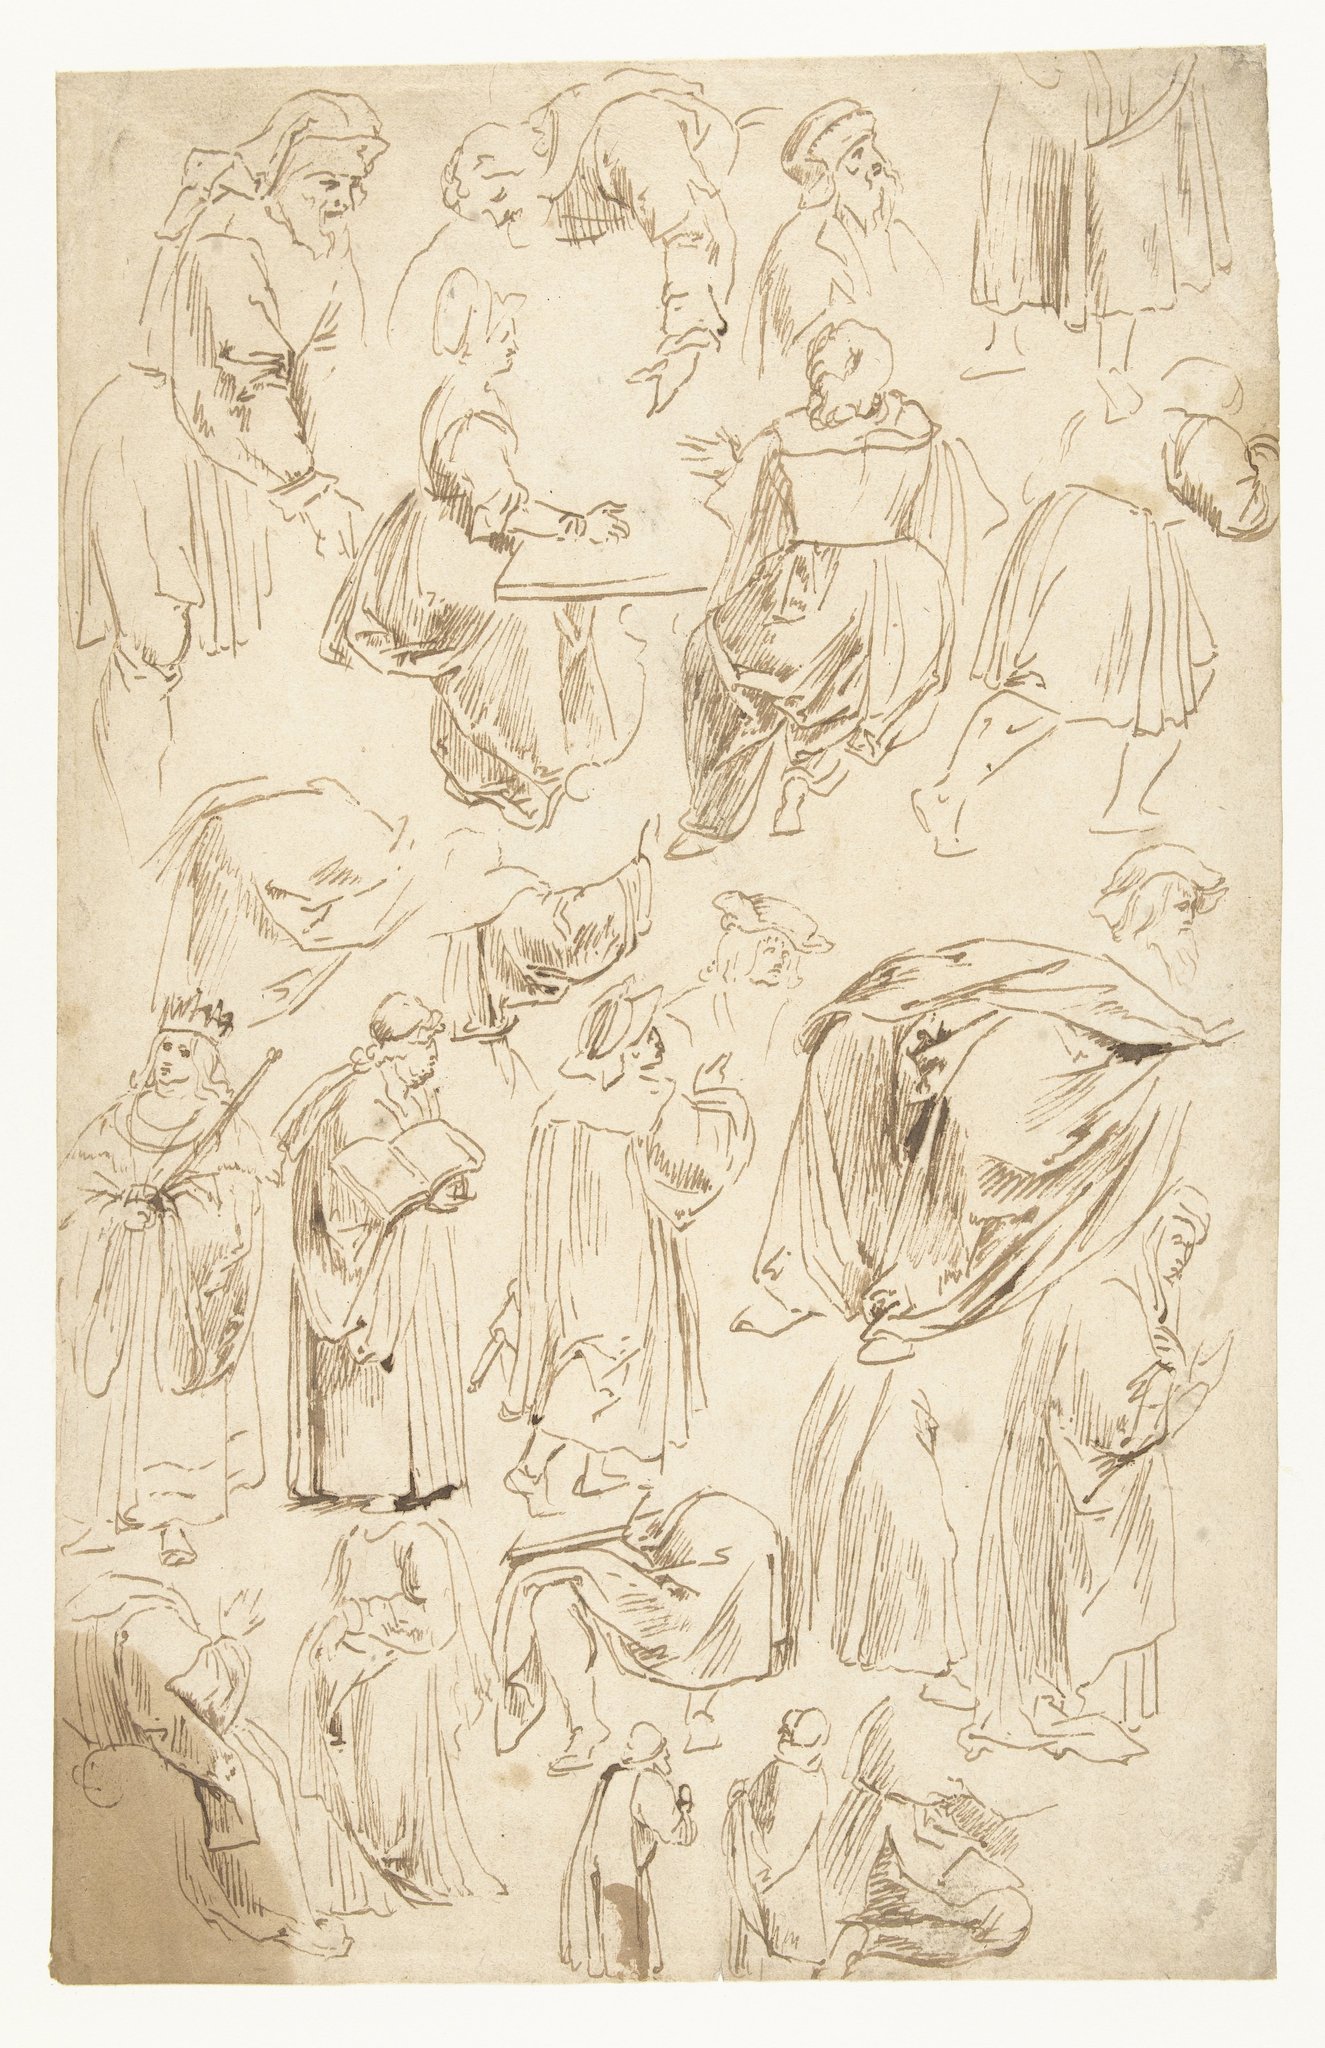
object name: drawing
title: Studies naar figuren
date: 1587-1640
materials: ink, paper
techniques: pen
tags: the (nude) human figure; 'corpo humano' (ripa)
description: Studies naar figuren in de Petrarca- en Cicero-illustraties van Hans Weiditz.